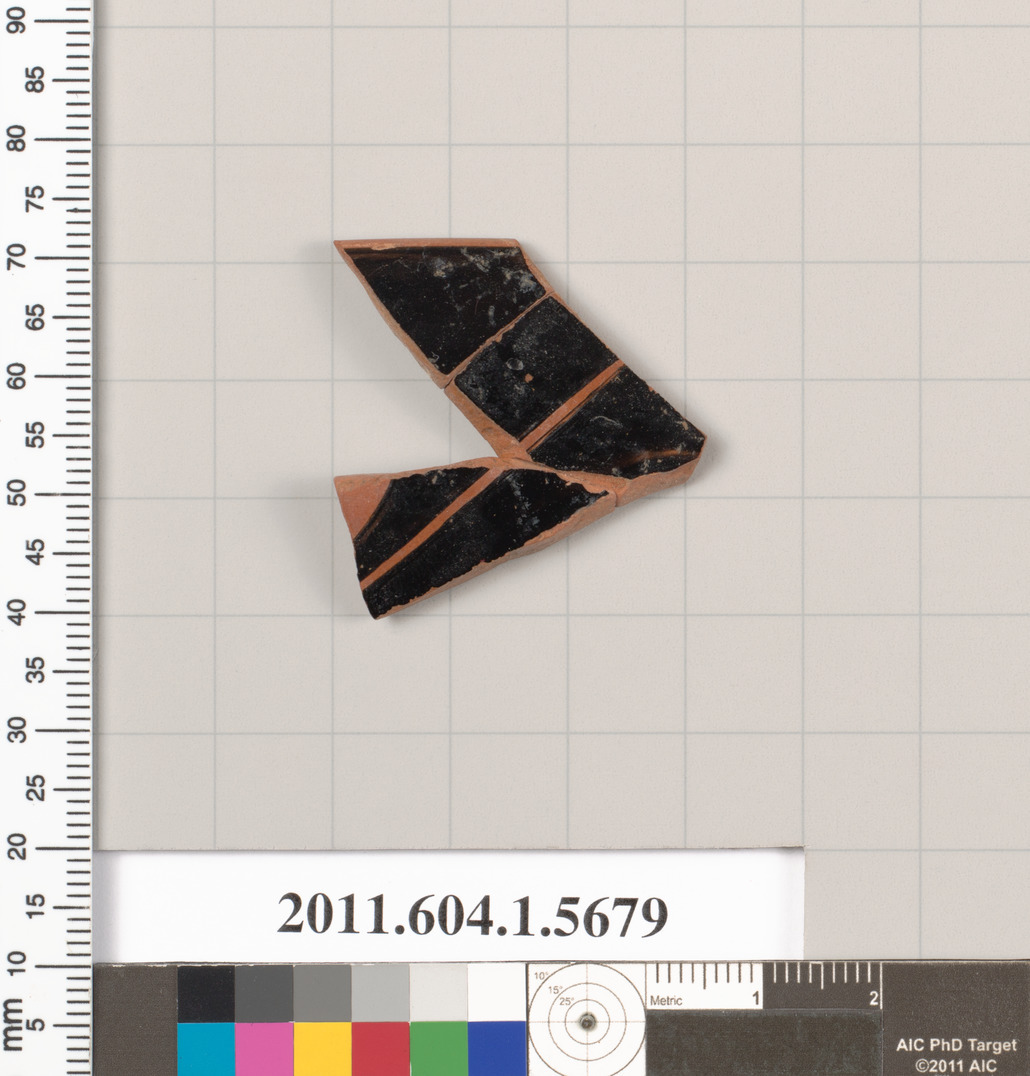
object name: kylix fragment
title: Terracotta rim fragment of a kylix (drinking cup)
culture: greek, attic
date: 500-480 BCE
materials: terracotta